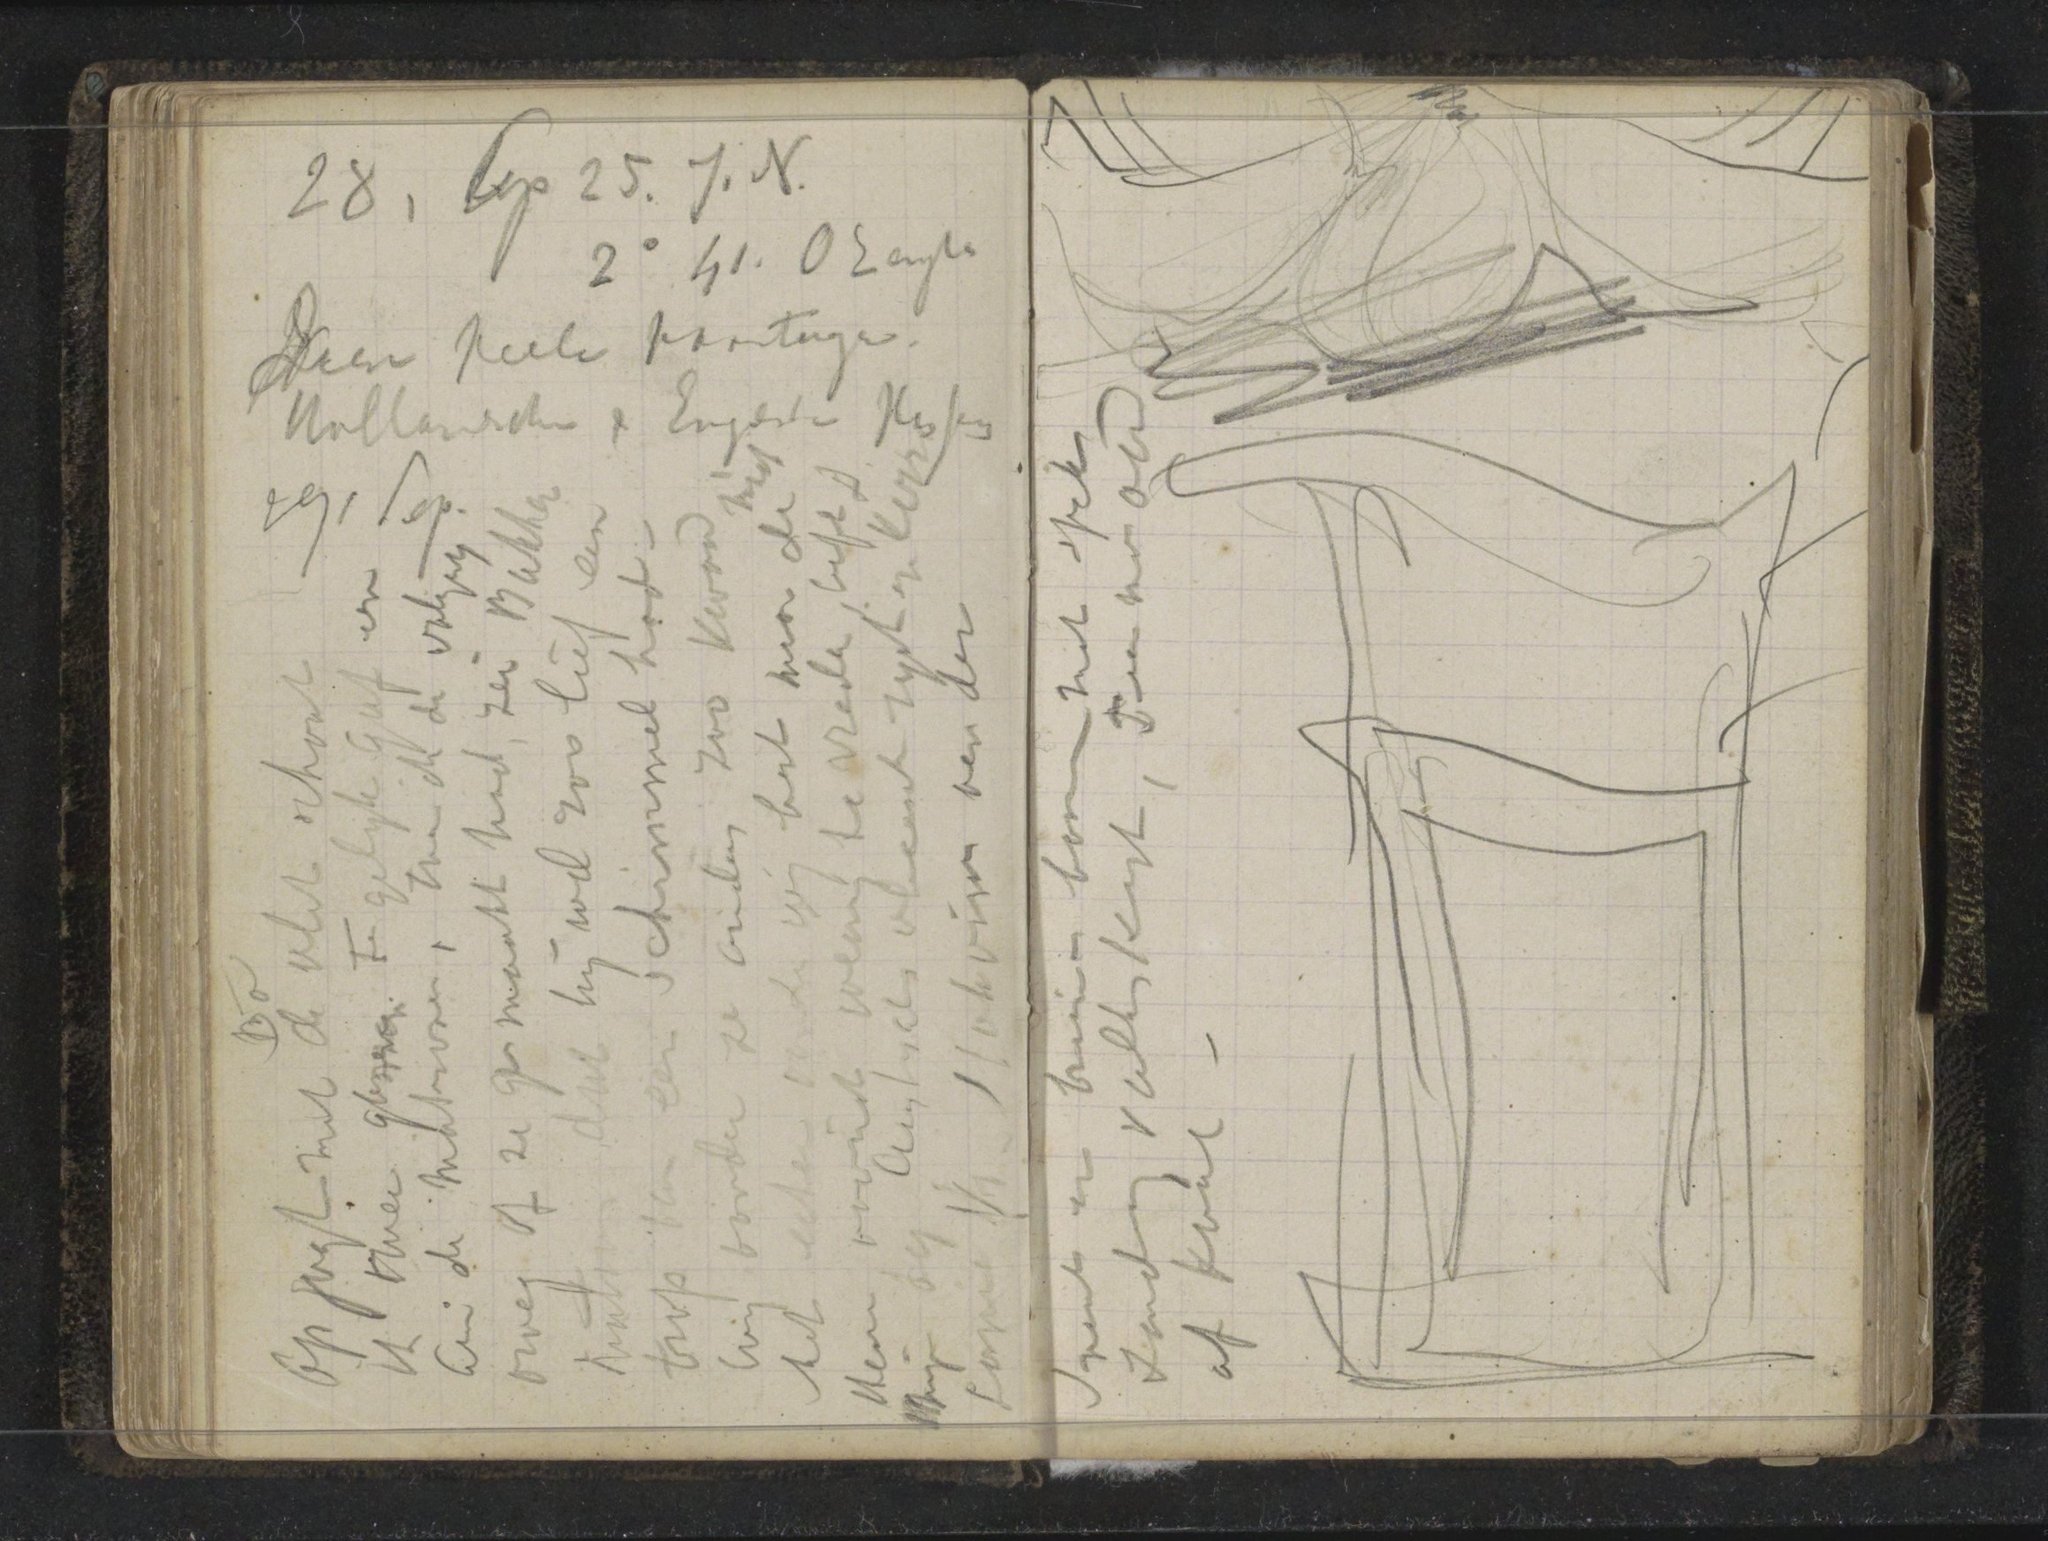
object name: sketchbook leaf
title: Reisverslag van eind september 1880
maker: louis apol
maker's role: draughtsman, painter, print maker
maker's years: 1850-1936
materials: pencil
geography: novaya zemlya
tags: nova zembla expedities 1880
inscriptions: annotation: ‘[...]’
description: Blad 39 verso en blad 40 recto uit een schetsboek met 110 bladen betekend tijdens de expeditie naar Nova Zembla in 1880.